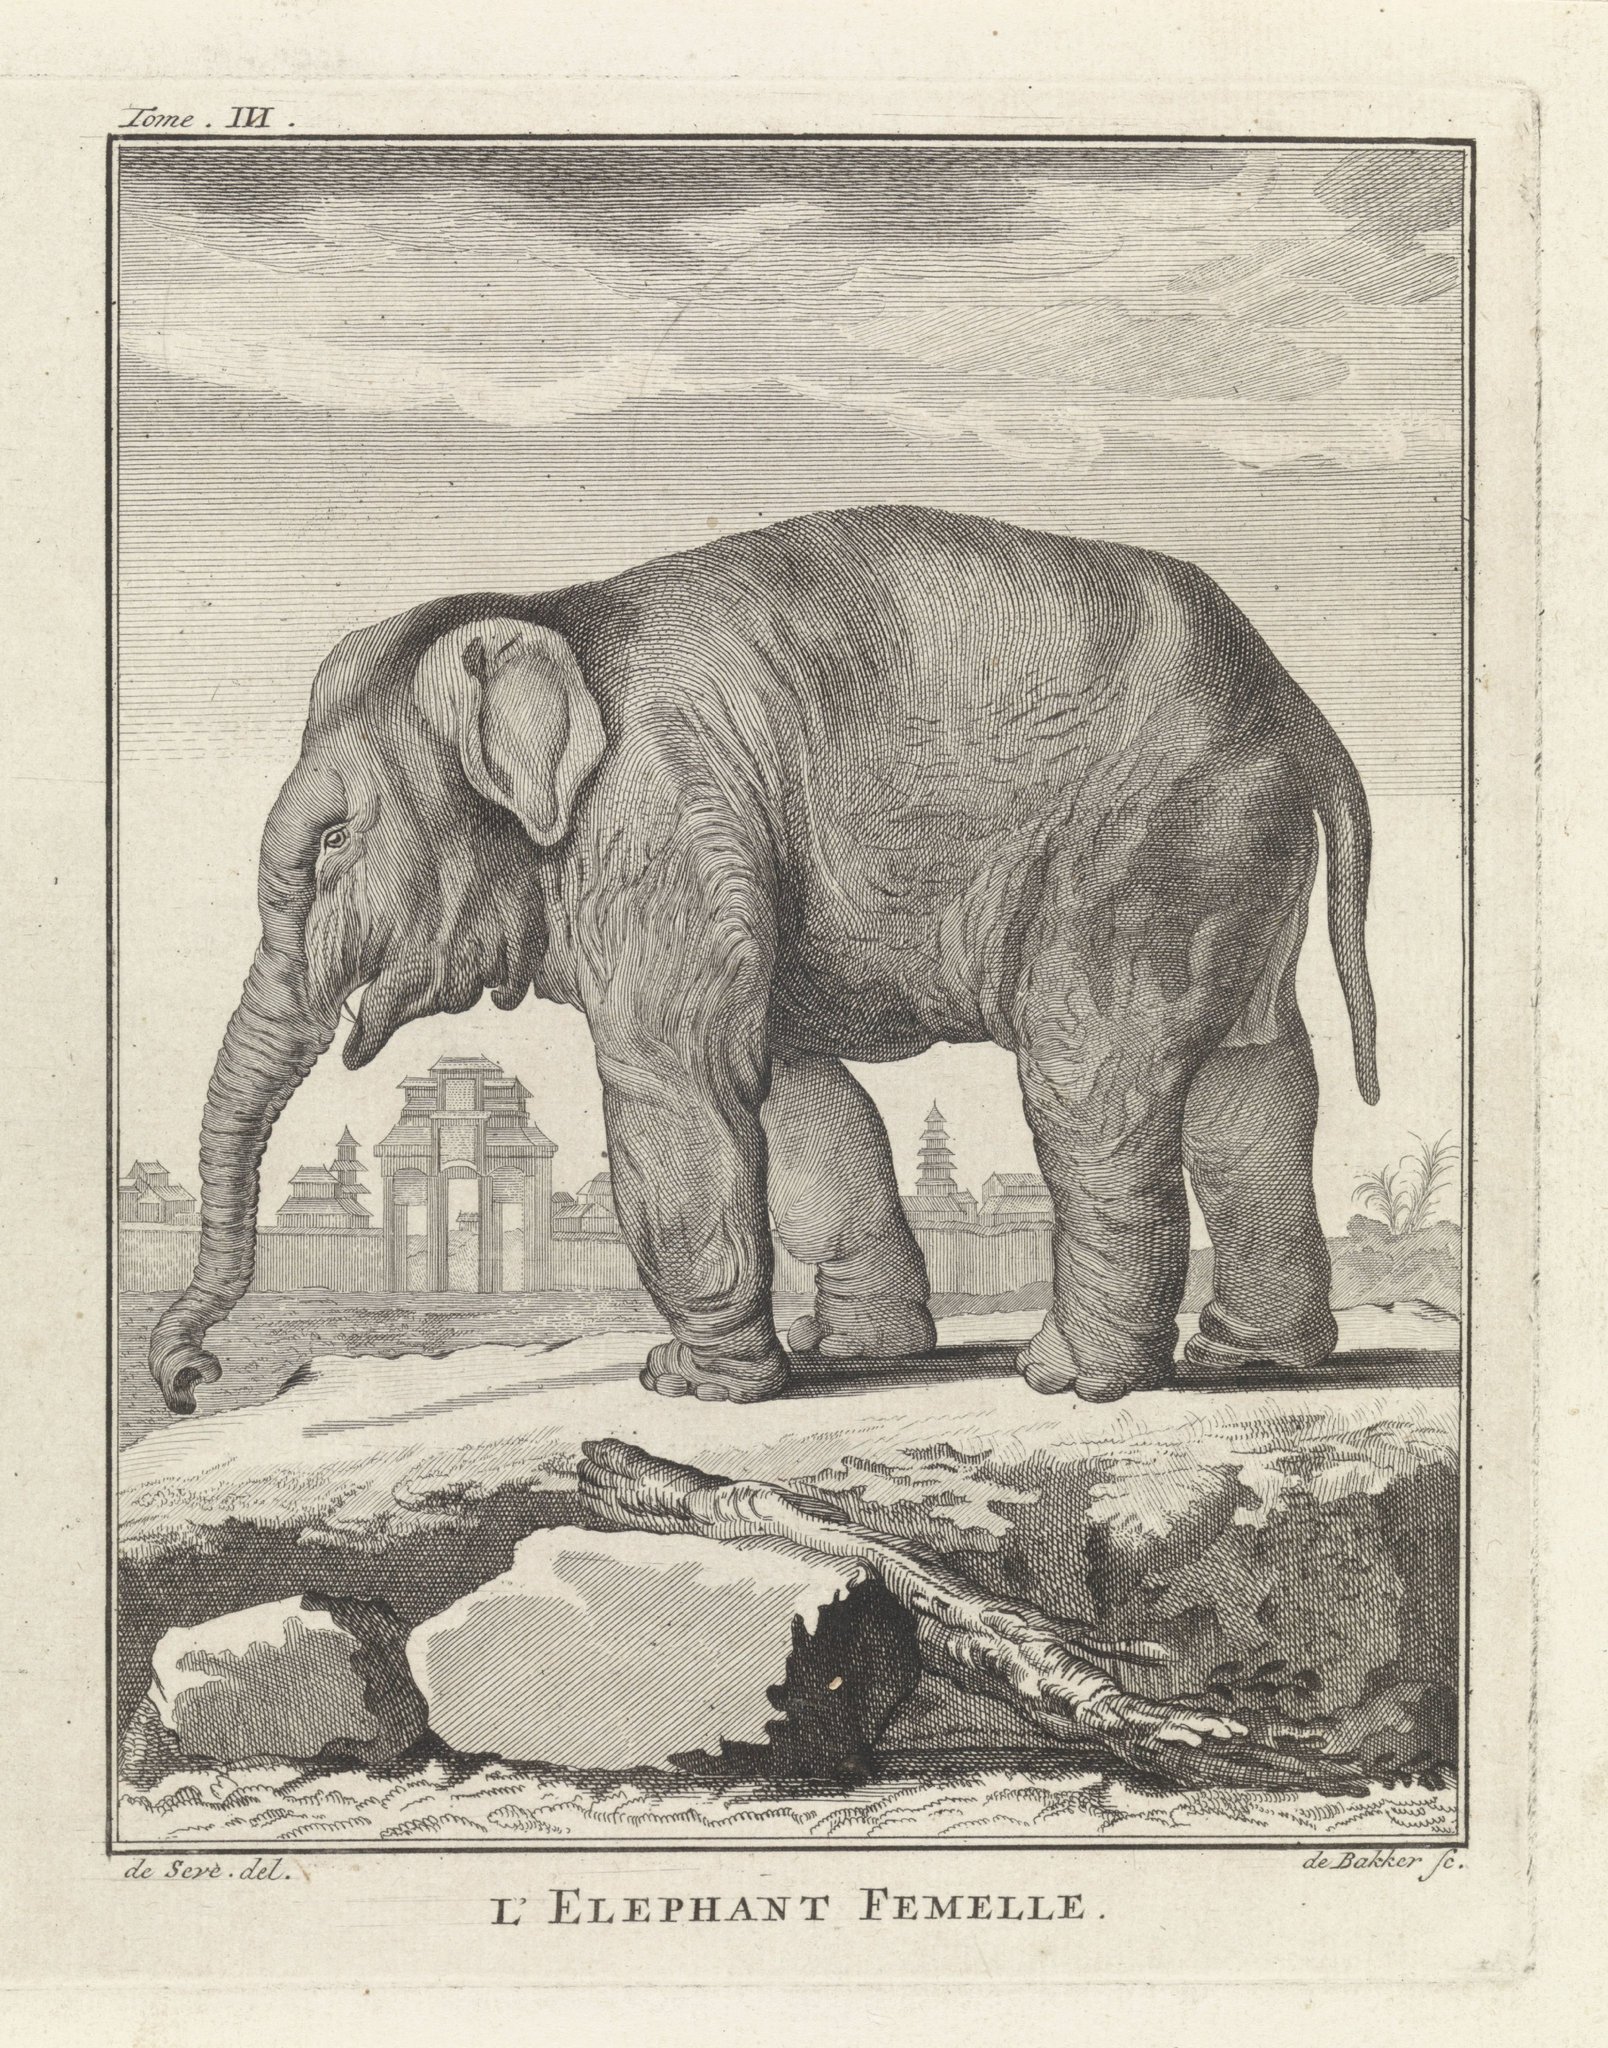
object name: print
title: Olifant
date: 1762-1804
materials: paper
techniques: engraving, etching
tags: trunked animals: elephant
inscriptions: collector's mark: Lugt 2228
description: Prent naar tekening van De Seve. Prent gebruikt voor onbekende uitgave, deel 3.